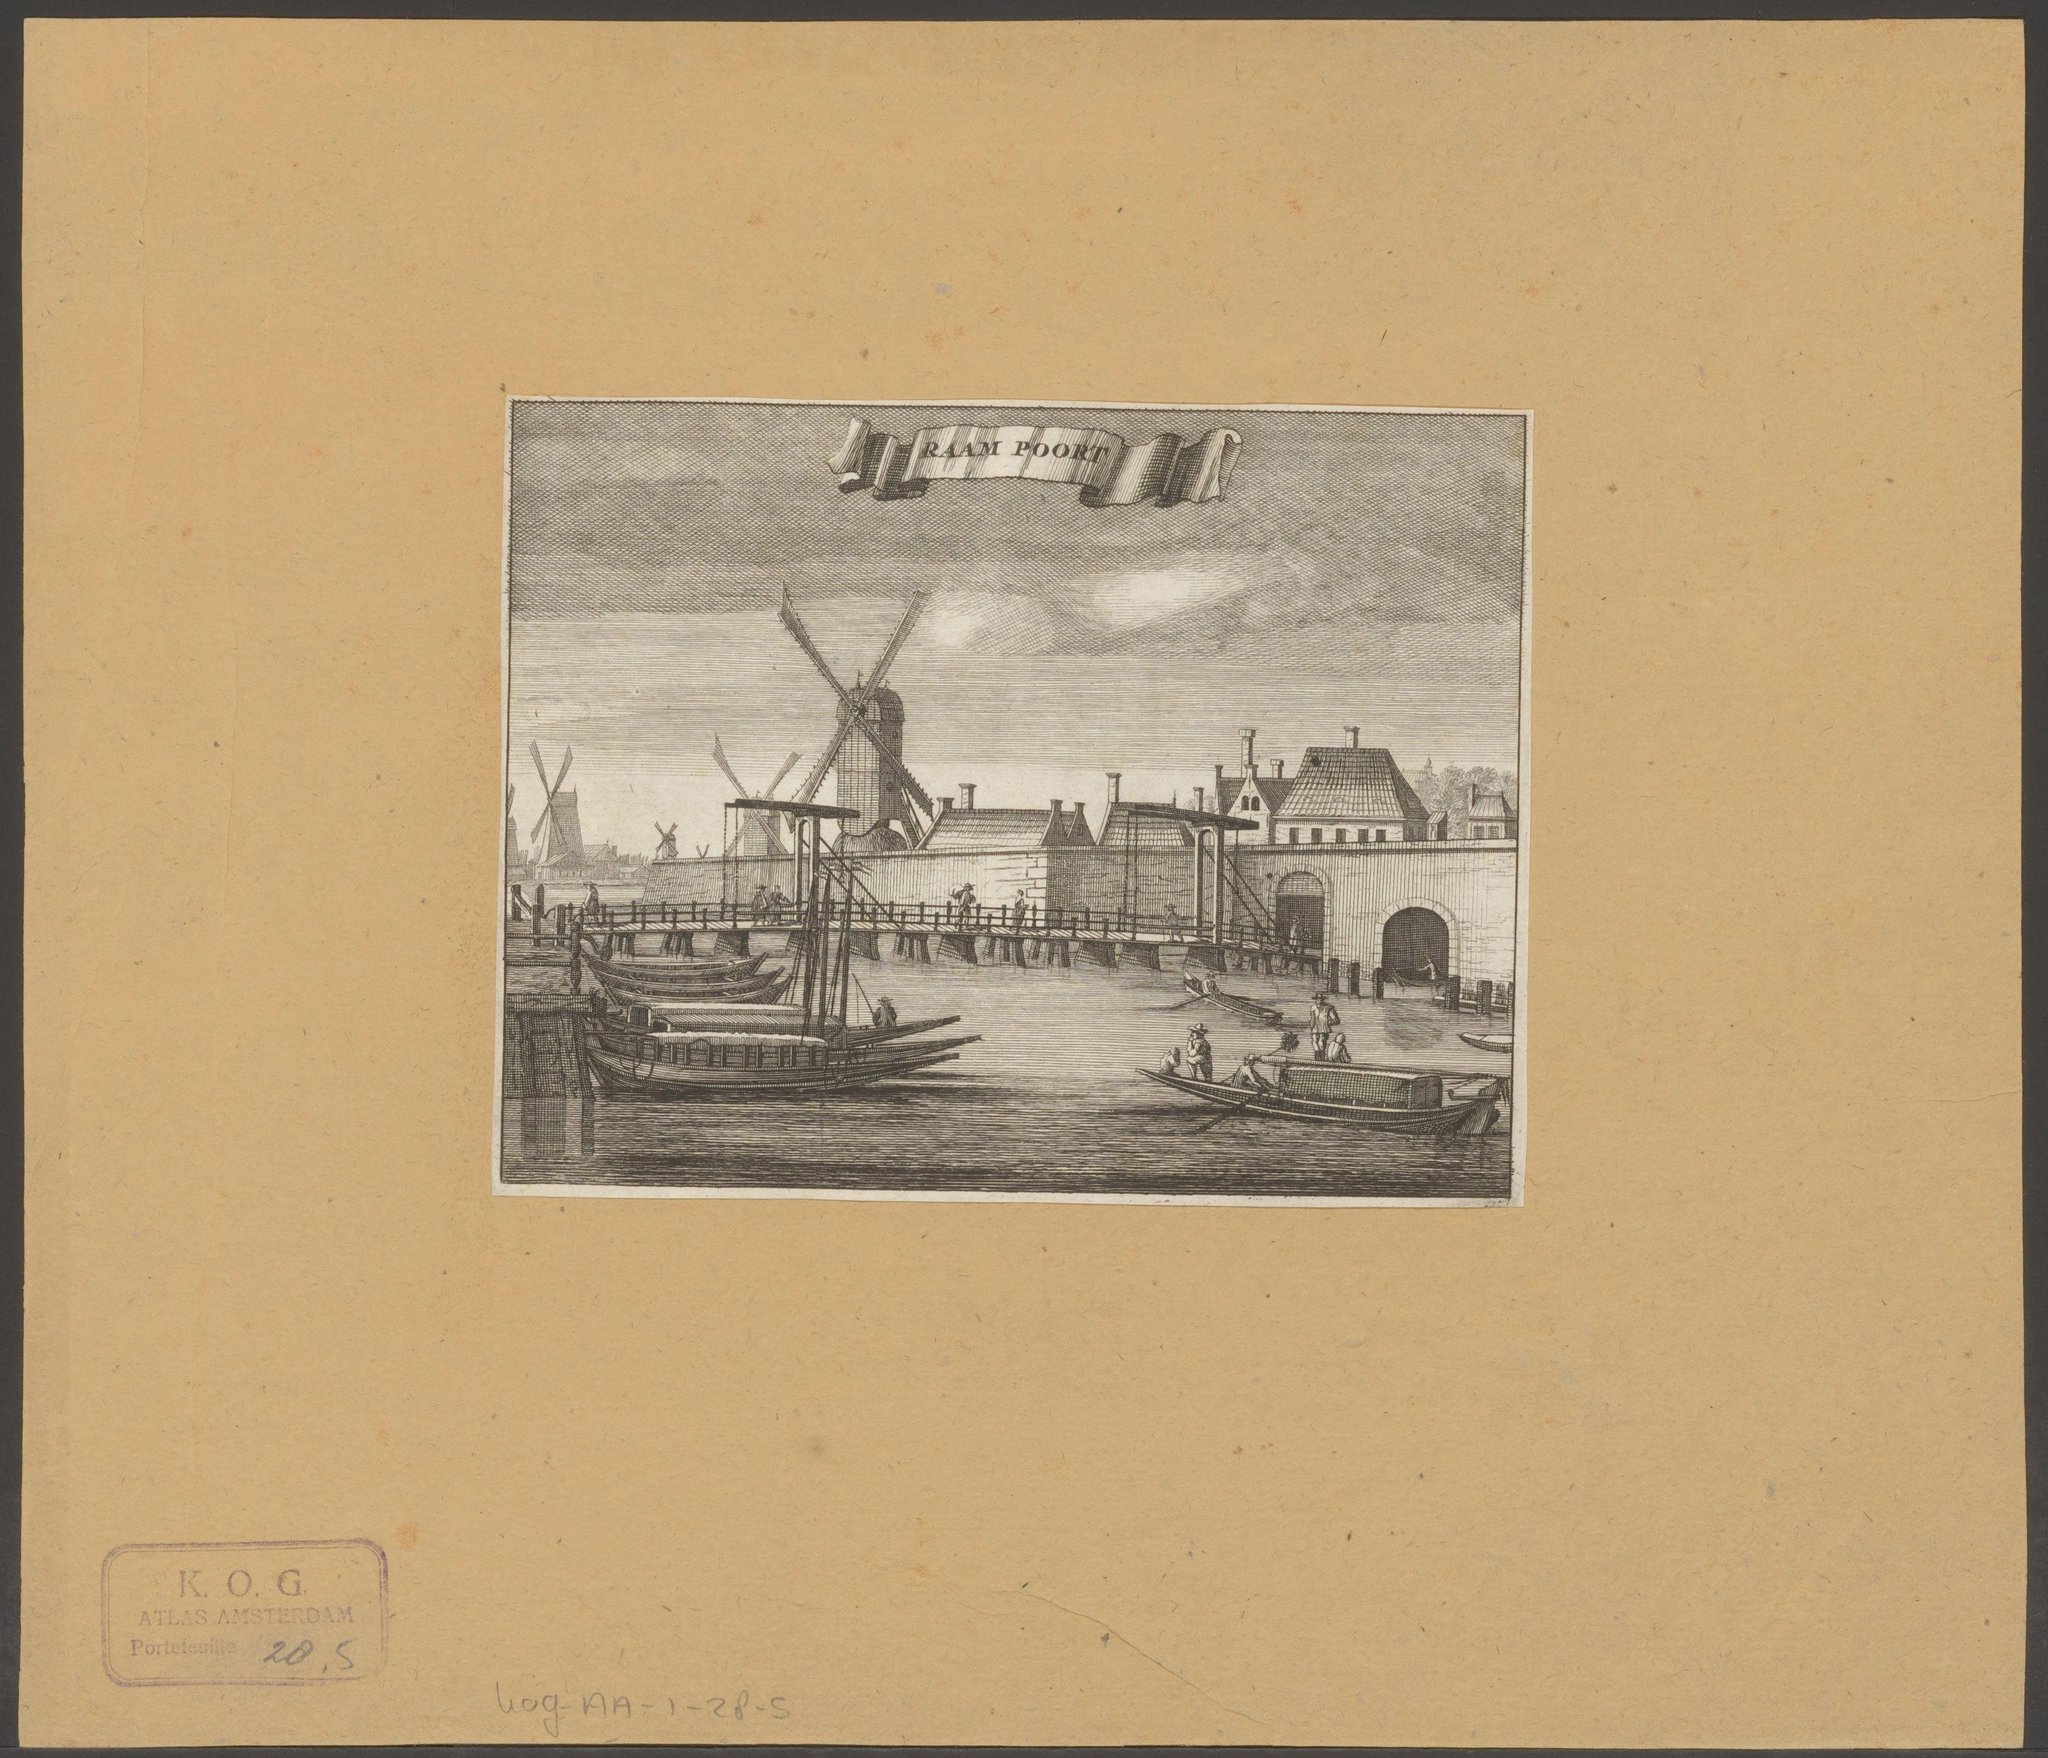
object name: book illustration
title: Raam poort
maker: Anonymous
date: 1693-1694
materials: paper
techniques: engraving, etching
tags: bridge, windmill, city-gate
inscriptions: collector's mark: Lugt 1641b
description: Huidige staat van prent ook gebruikt in: Commelin, Caspar. Beschryvinge van Amsterdam, zynde een naukeurige verhandelinge van desselfs eerste oorspronk uyt (…). 2 dln. 2de druk. Amsterdam: Andries van Damme, Johannes Ratelband, weduwe A. van Aaltwyk en Hermanus Uytwerf, 1726. Latere staat ook gebruikt in: Commelin, Caspar. Beschryvinge van Amsterdam, desselfs eerste oorspronk uyt den Huyse (…). 2 dln. Amsterdam: Abraham Wolfgang, Gillis Janssonius van Waesberge, Johannes Janssonius van Waesberge II, weduwe Dirk Boom I, Hendrick Boom en Rembertus Goethals, 1693. En in: Commelin, Caspar. Beschryvinge van Amsterdam, zynde een naukeurige verhandelinge van desselfs eerste oorspronk uyt (…). 2 dln. Amsterdam: weduwe Aart Dircksz Oossaan, 1694.